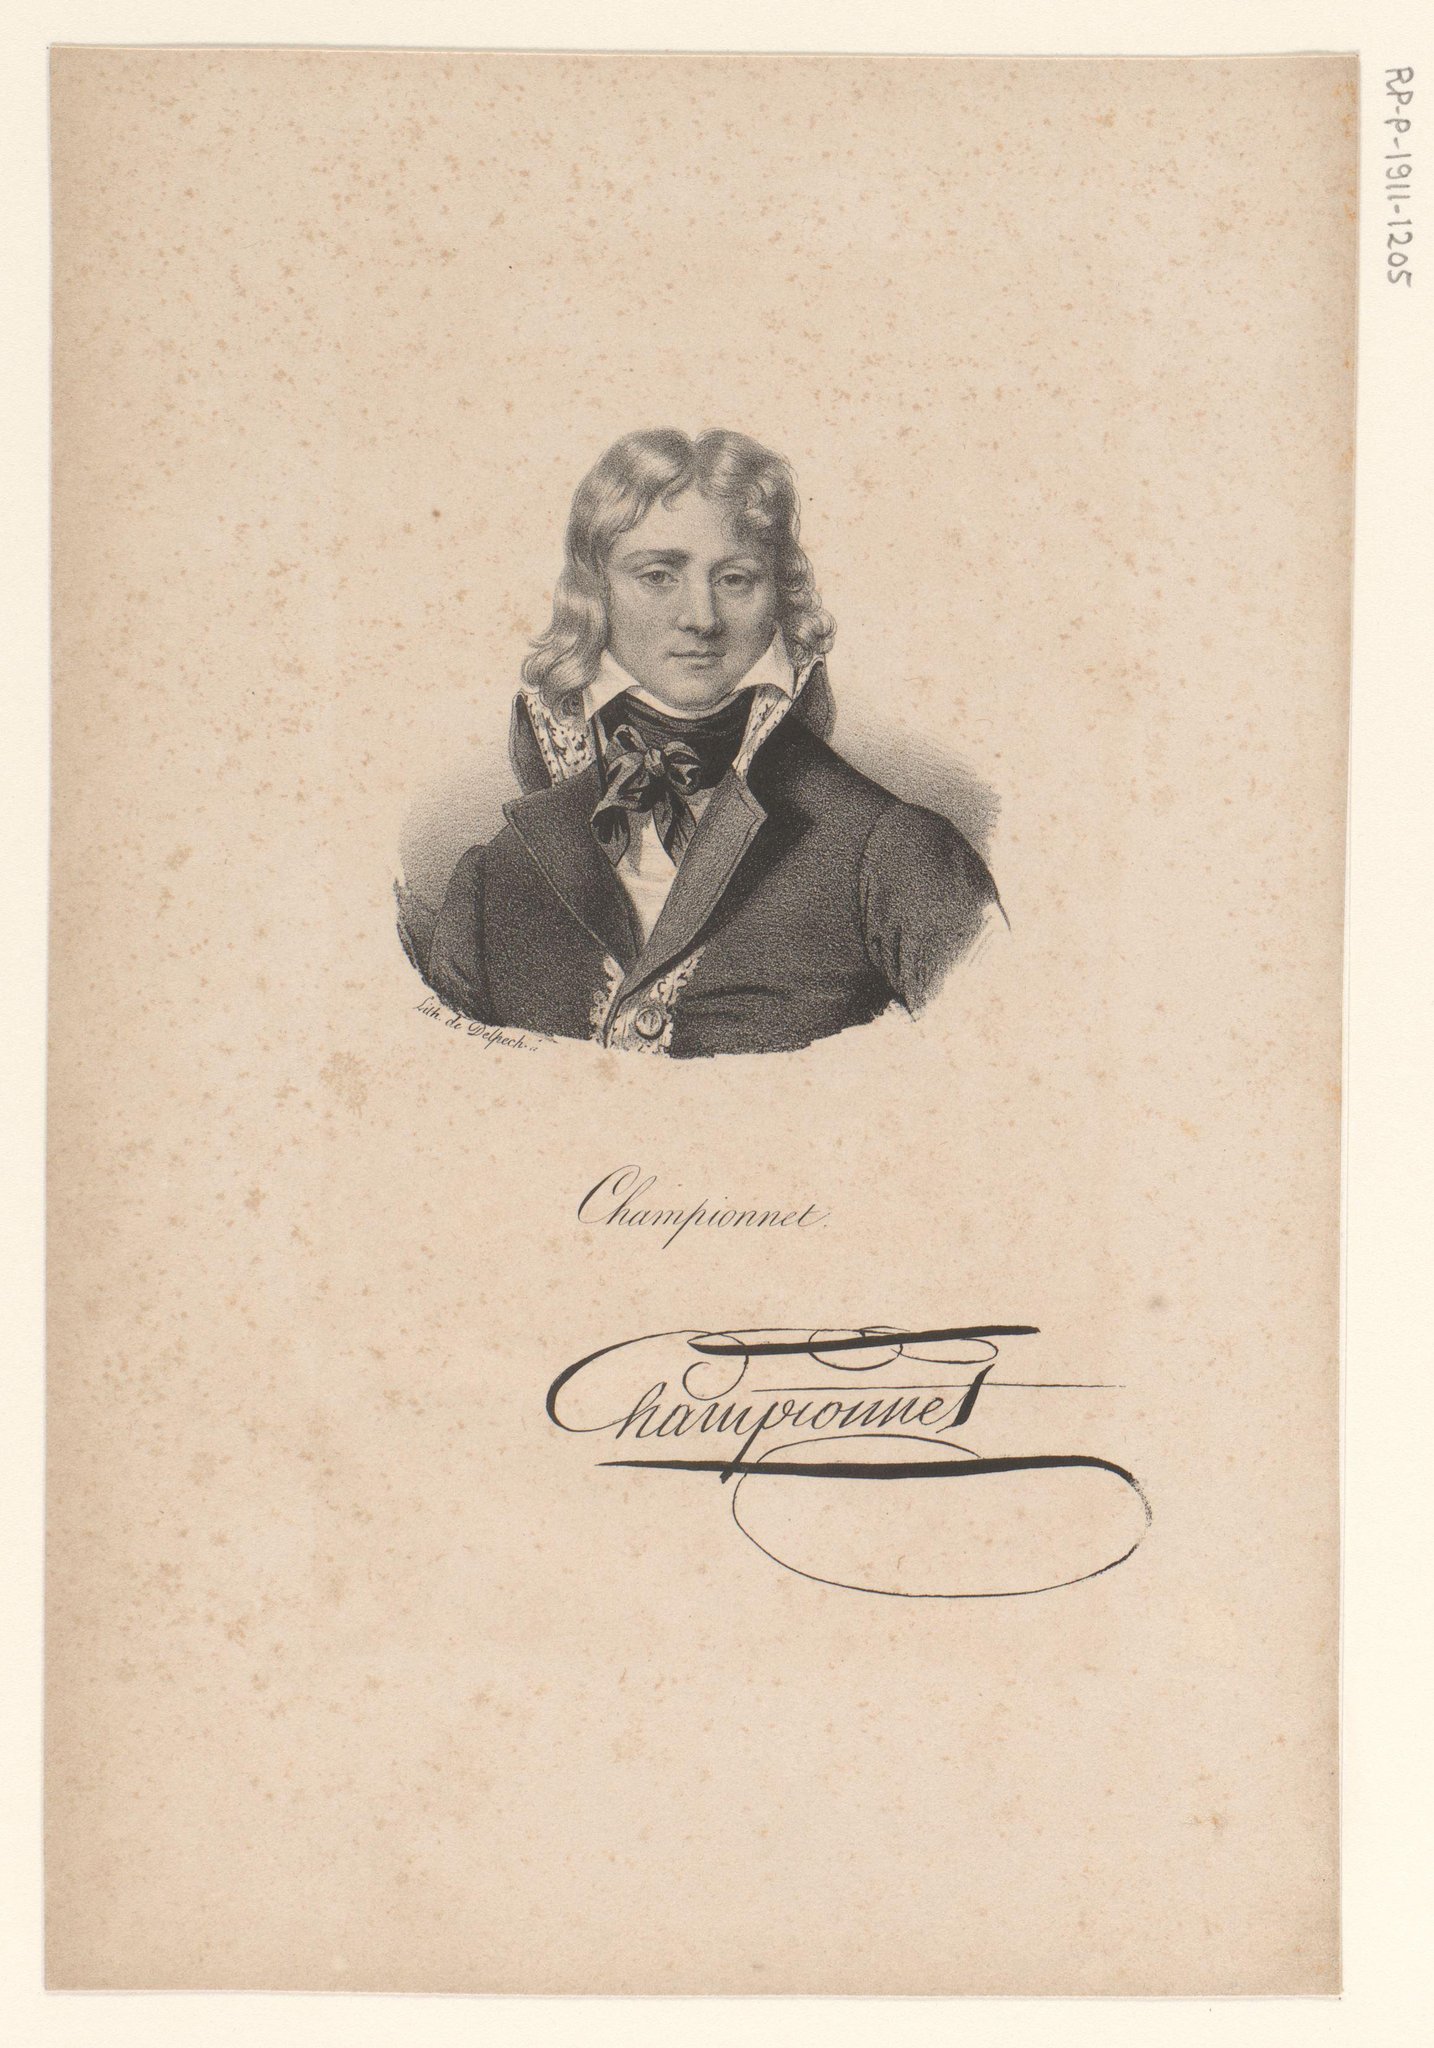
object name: print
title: Championnet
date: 1830-1842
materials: paper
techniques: lithograph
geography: paris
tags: historical persons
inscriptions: collector's mark: Lugt 2228a